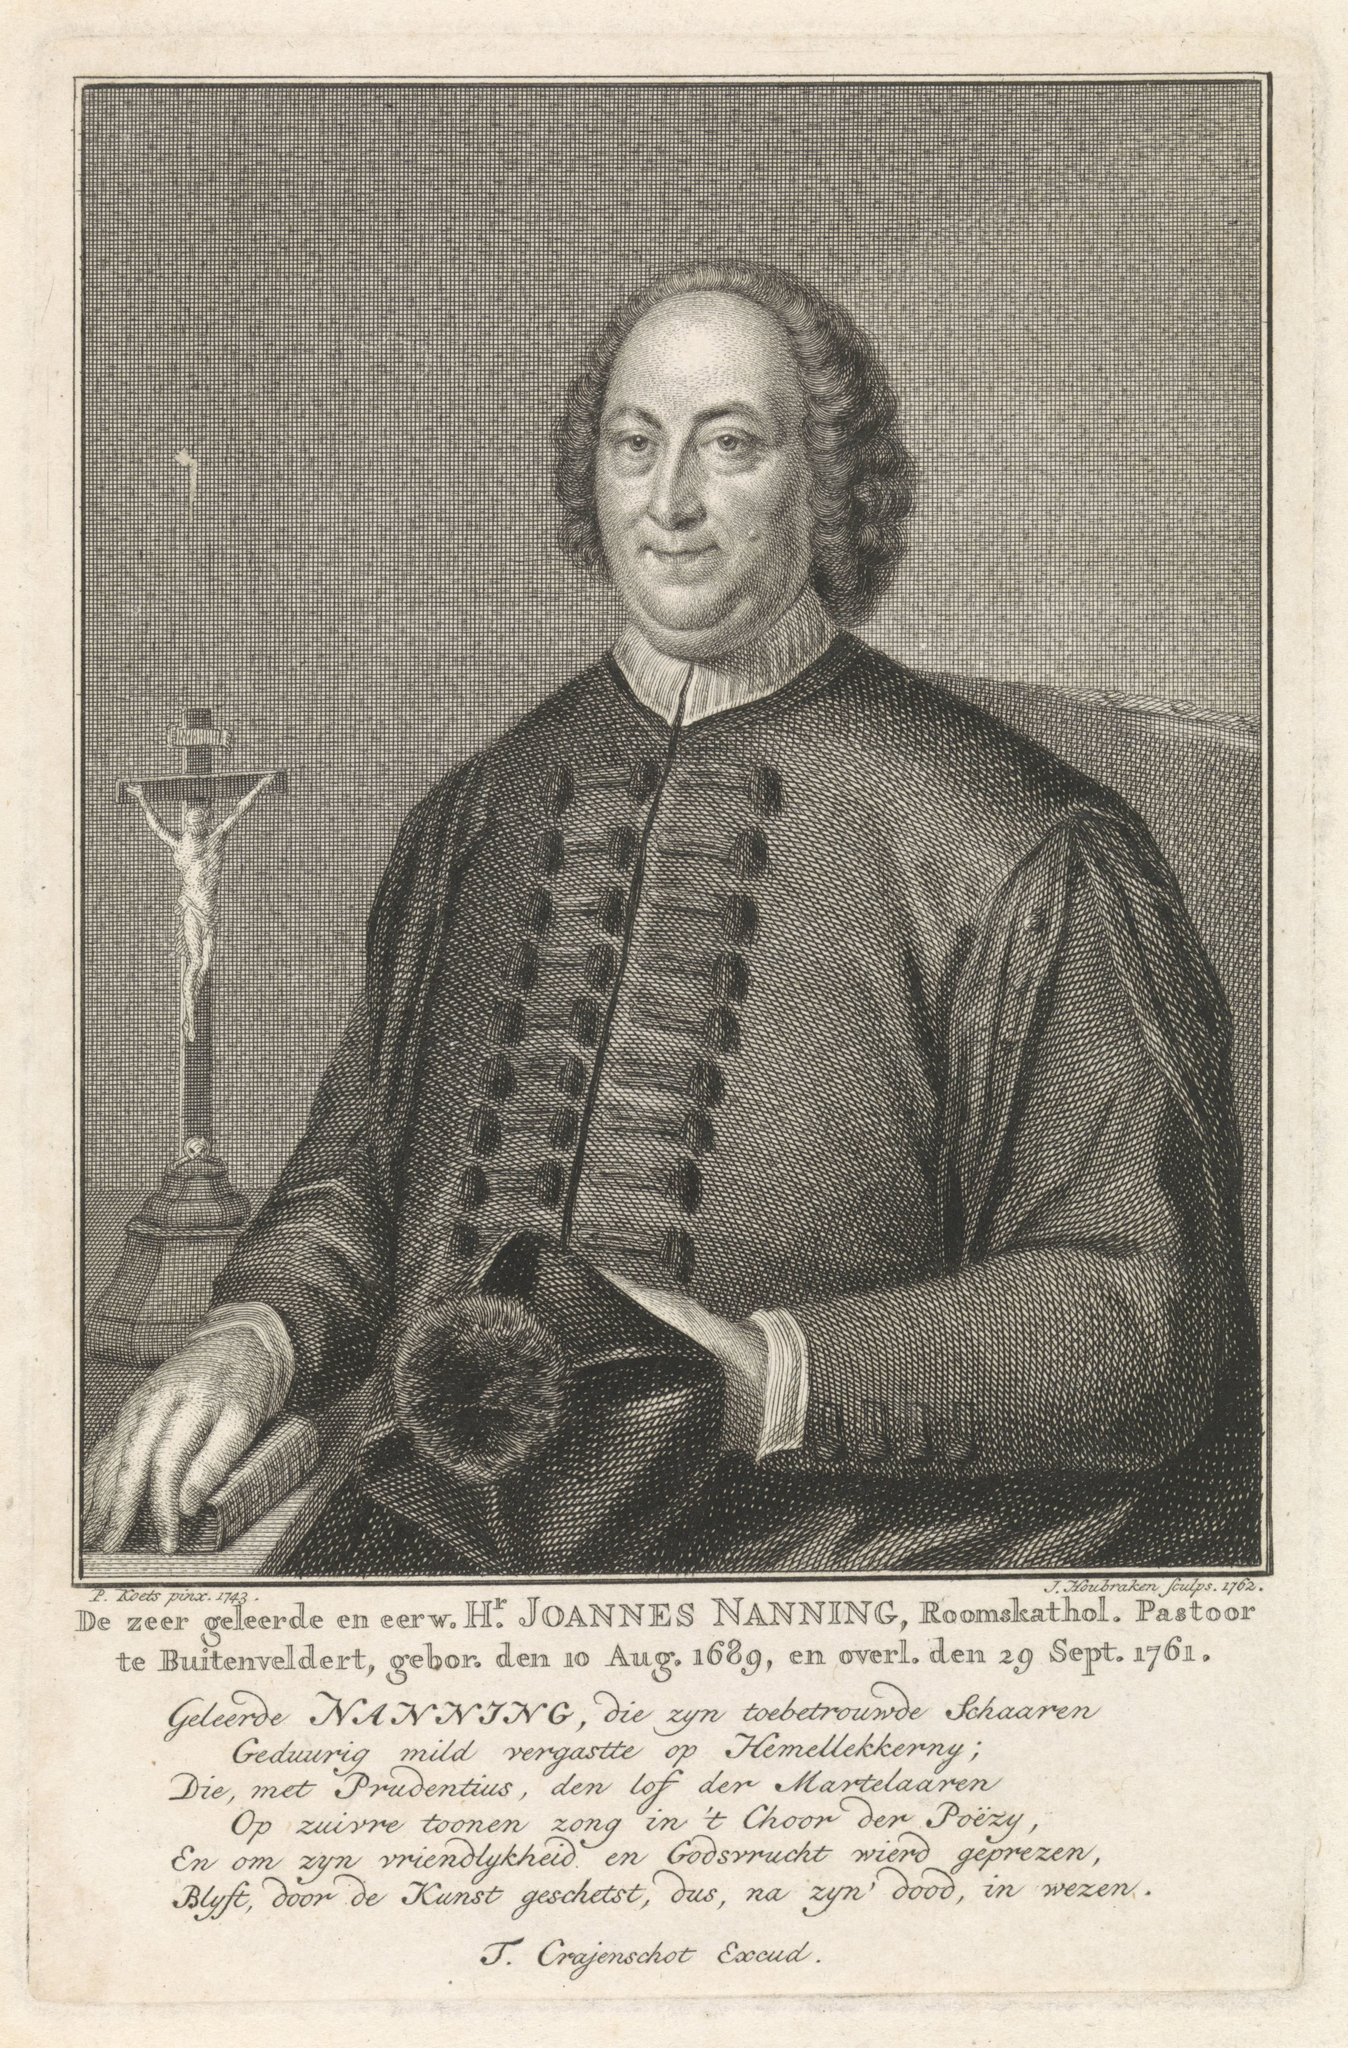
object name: print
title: Portret van Joan Nanning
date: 1762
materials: paper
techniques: engraving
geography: amsterdam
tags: priest, joan nanning, crucifix ~ personal devotion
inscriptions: collector's mark: Lugt 2228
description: Portret ten halven lijve naar links van Joan Nanning, zittend op een stoel met links een tafel waarop een crucifix, zijn rechterhand rustende op een bijbel. In zijn linkerhand houdt hij zijn bonnet. Onder het portret zijn naam en gegevens in twee regels in het Nederlands en daaronder een zesregelig vers in het Nederlands.